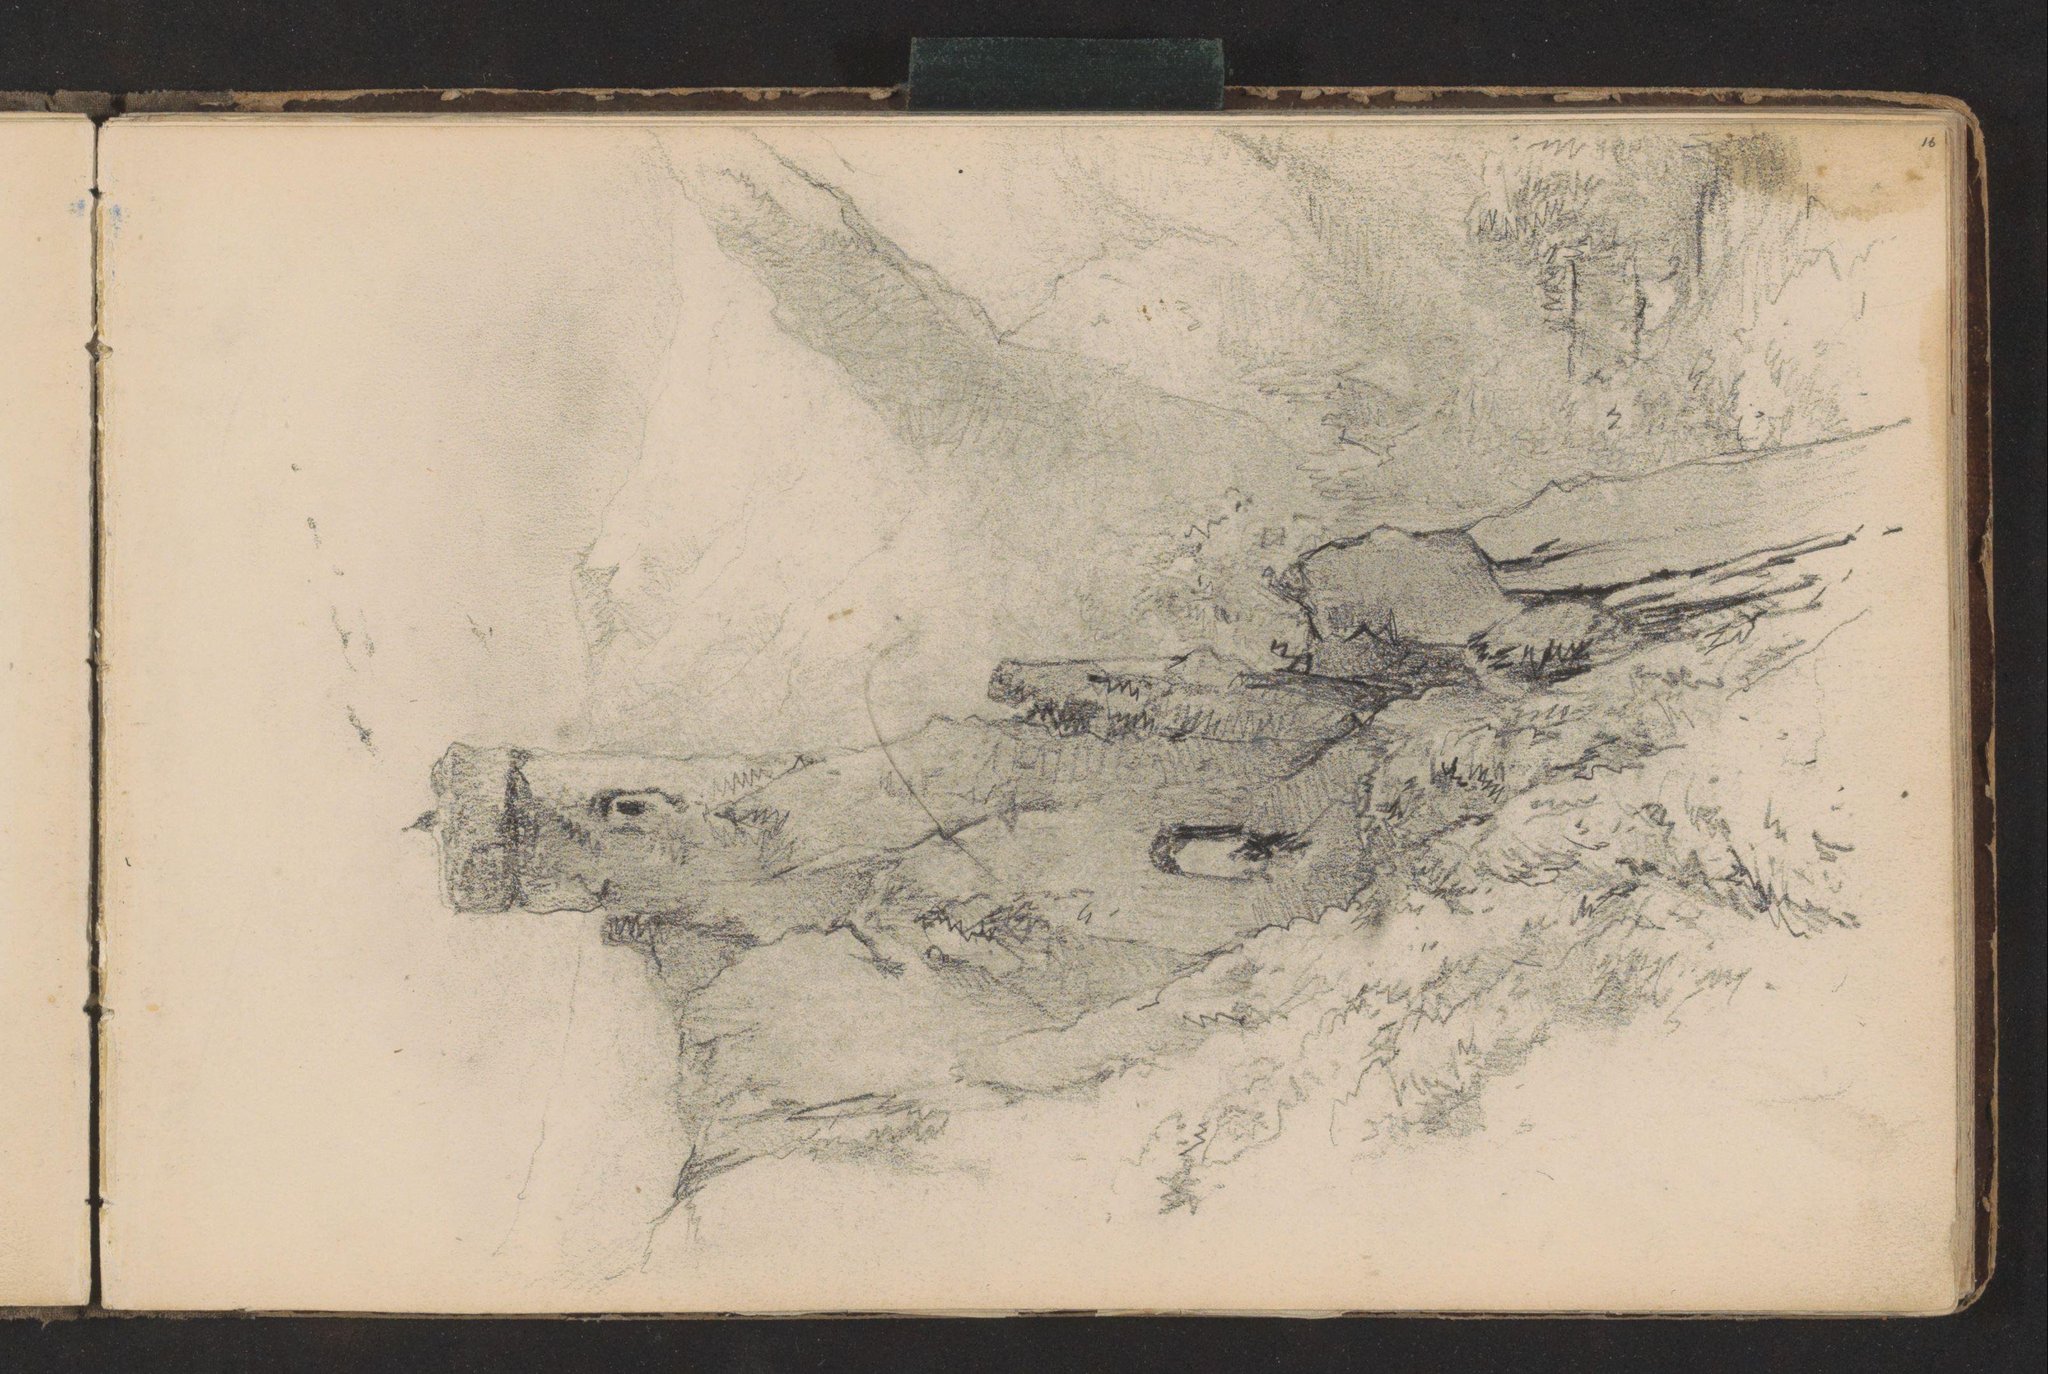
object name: sketchbook leaf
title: Berglandschap met een stenen toren naast een dal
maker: maria vos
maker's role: draughtsman, painter, print maker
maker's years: 1824-1906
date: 1871-1878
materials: paper, pencil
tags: dale, valley, landscape with tower or castle, mountains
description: Blad 16 recto uit een schetsboek met 45 bladen.